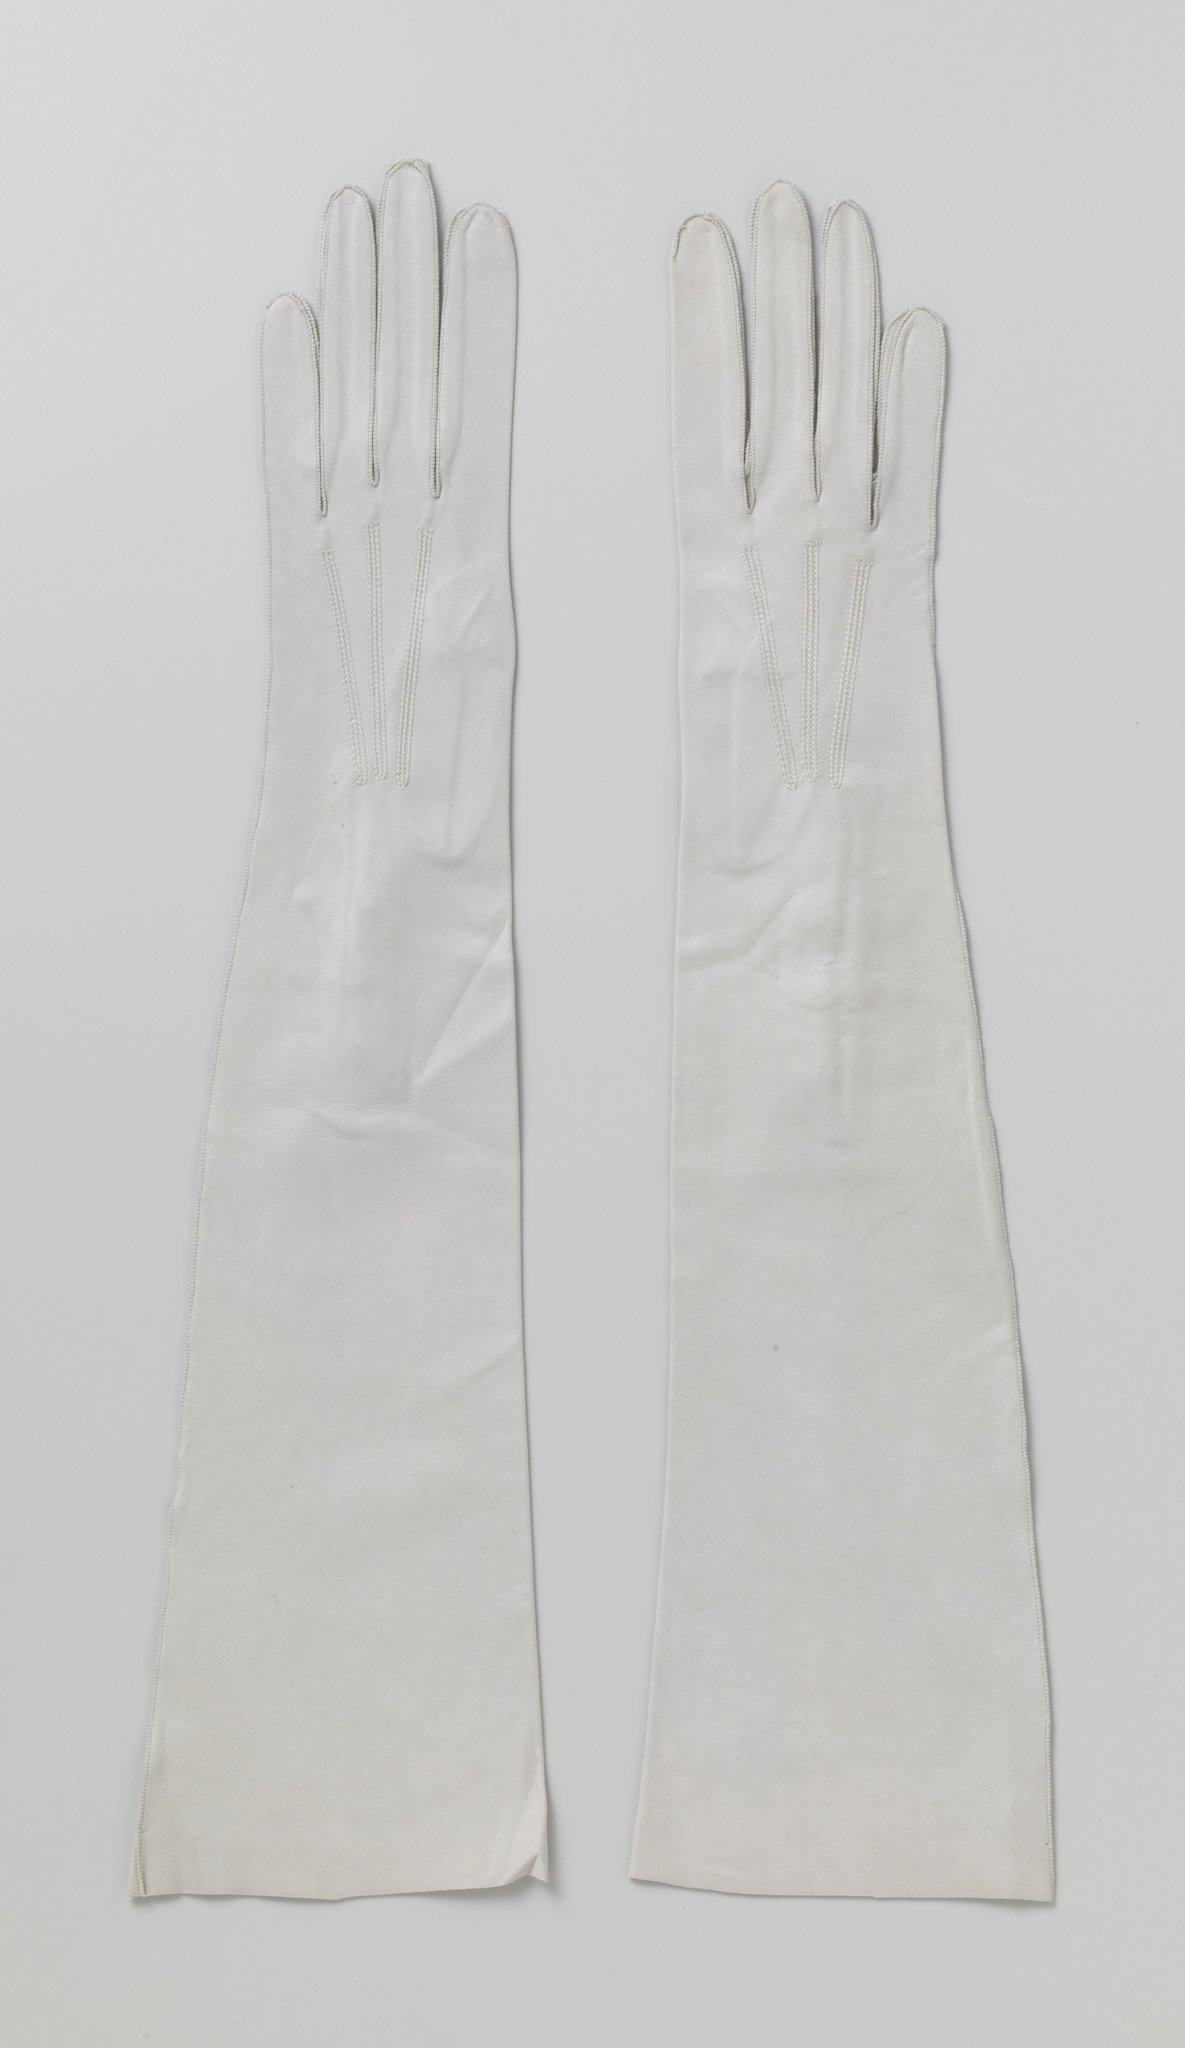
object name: glove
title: Pair of long gloves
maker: Anonymous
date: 1900-1915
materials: leather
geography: netherlands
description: Rechterhandschoen van grijs wasleer. Op de hand drie uitstralende koorden. Bij de pols een split met drie parelmoerkleurige knopen.